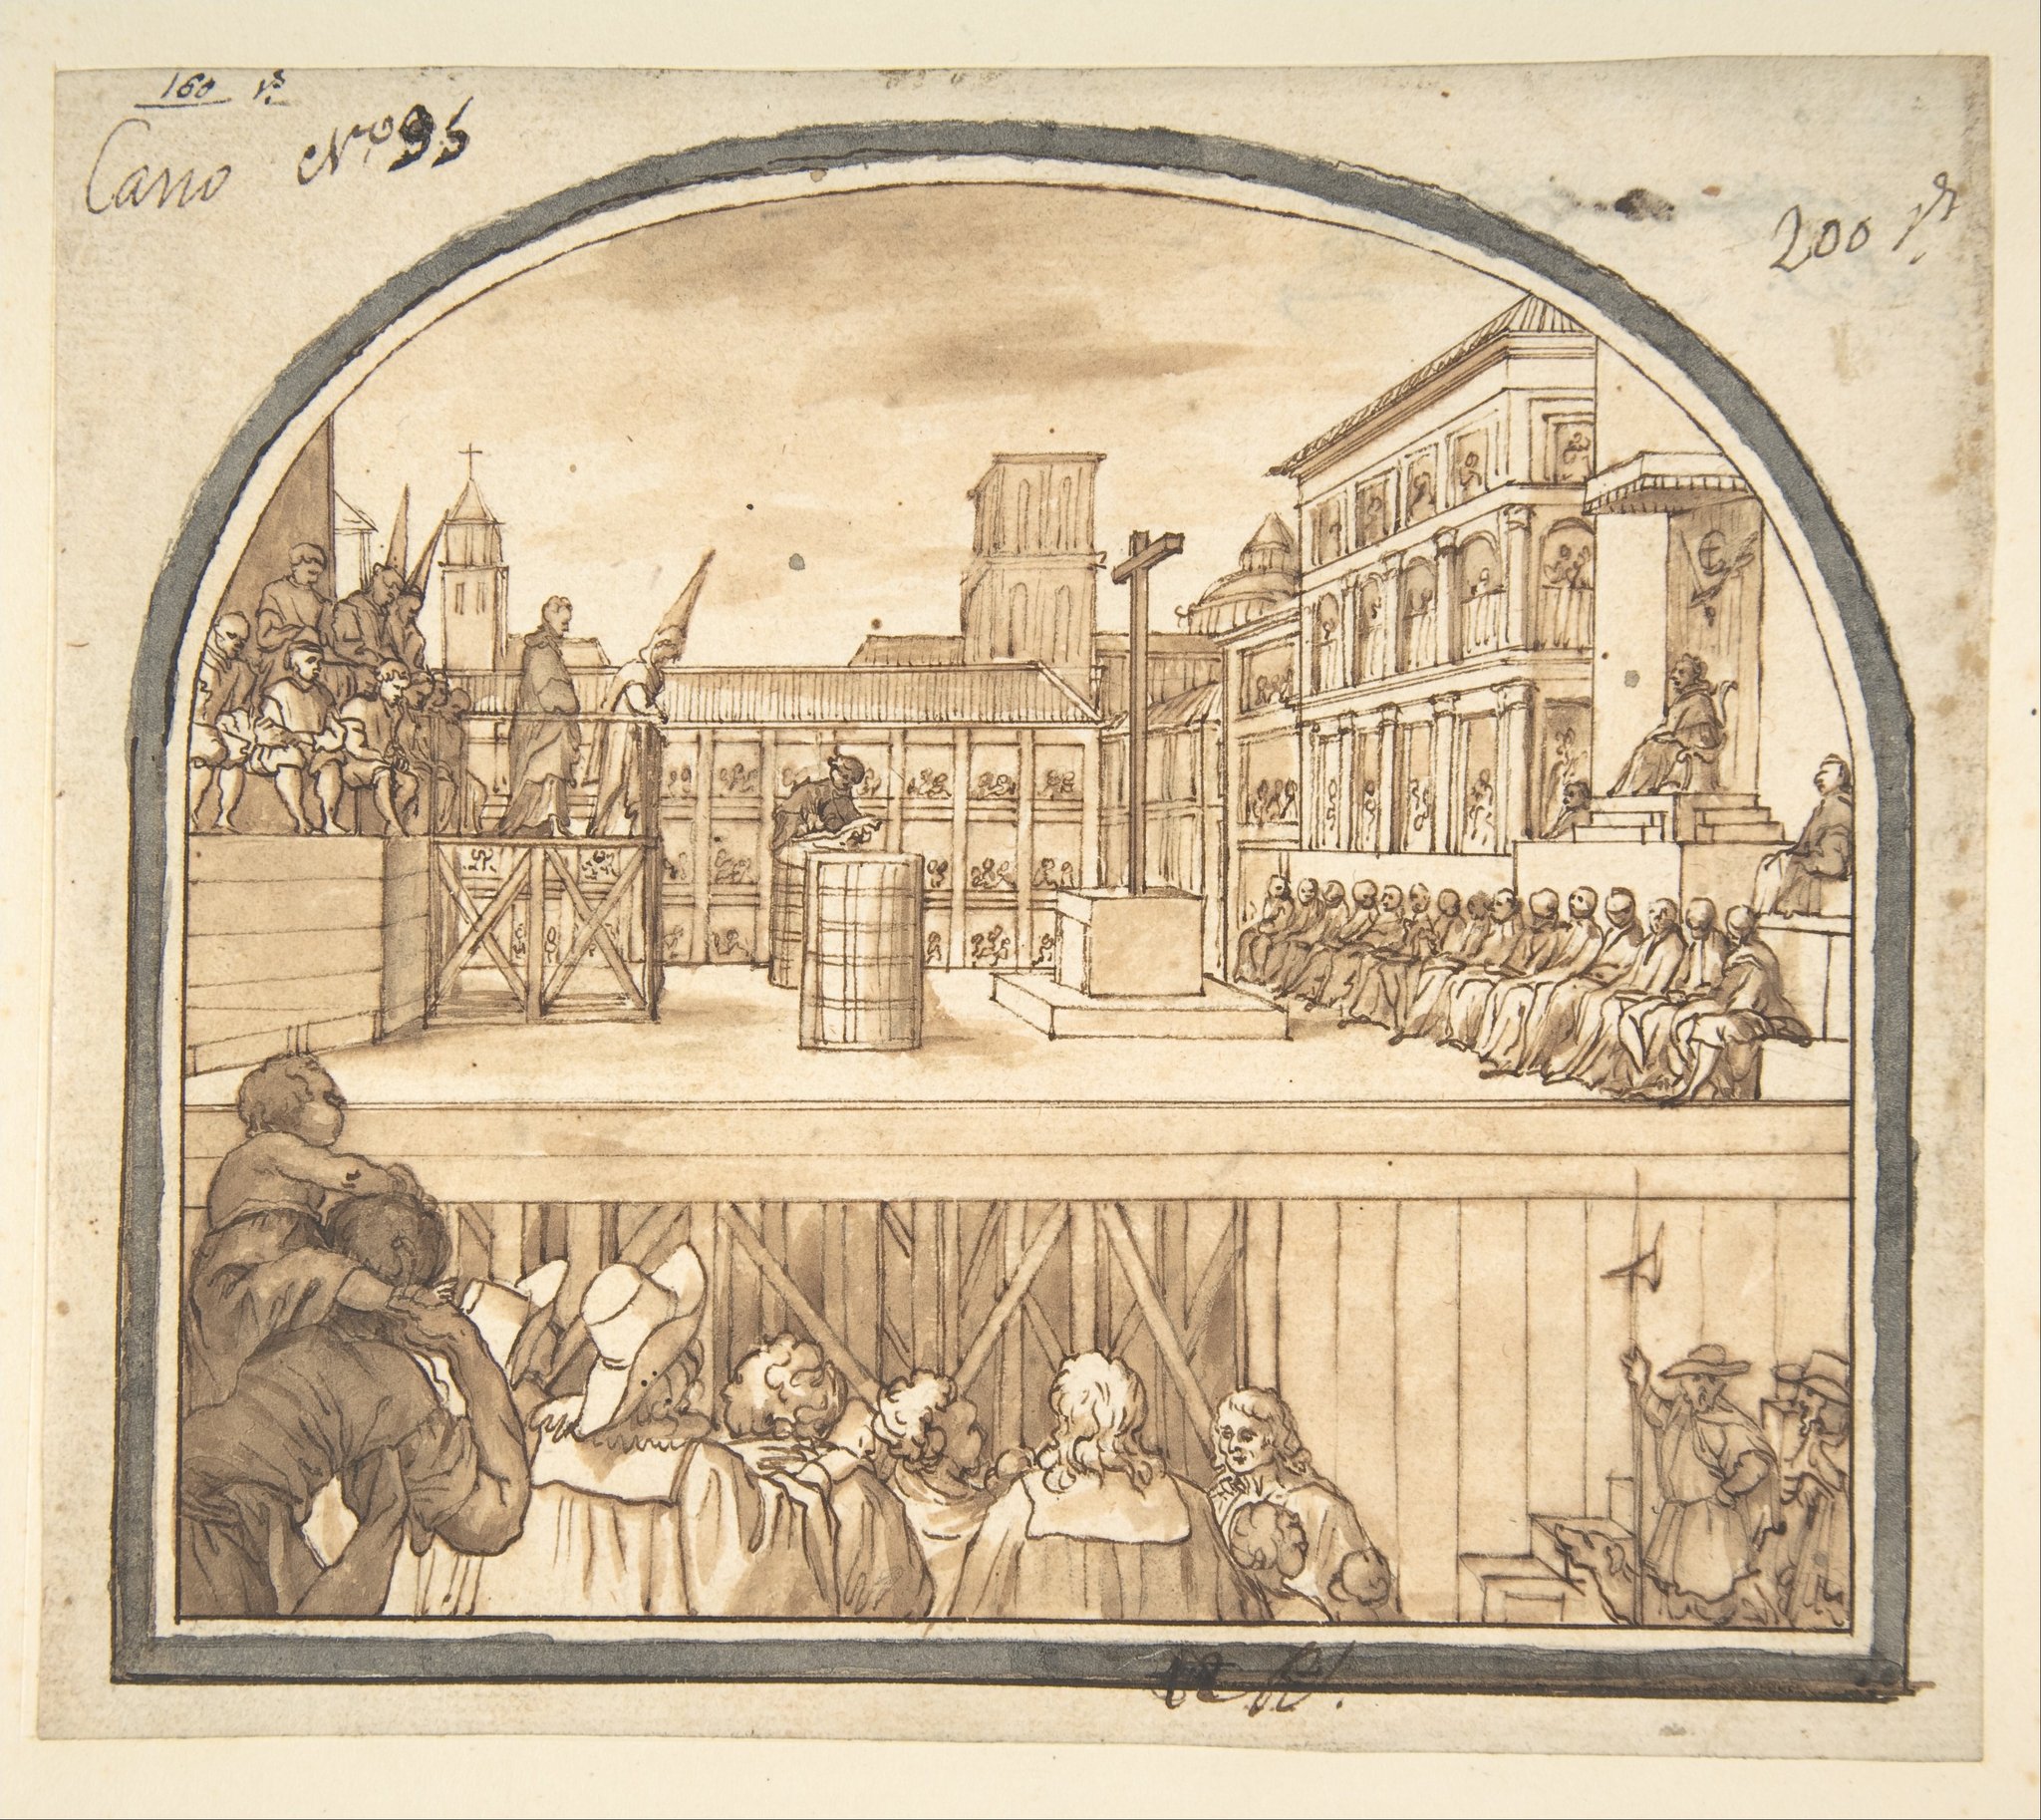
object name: drawing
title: Auto-da-fé in a Courtyard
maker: sebastián de herrera-barnuevo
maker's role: artist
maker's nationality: spanish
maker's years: 1619-1671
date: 1619-1671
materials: chalk, ink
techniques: brush, pen, drawing, wash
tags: buildings,courtyards,crowd